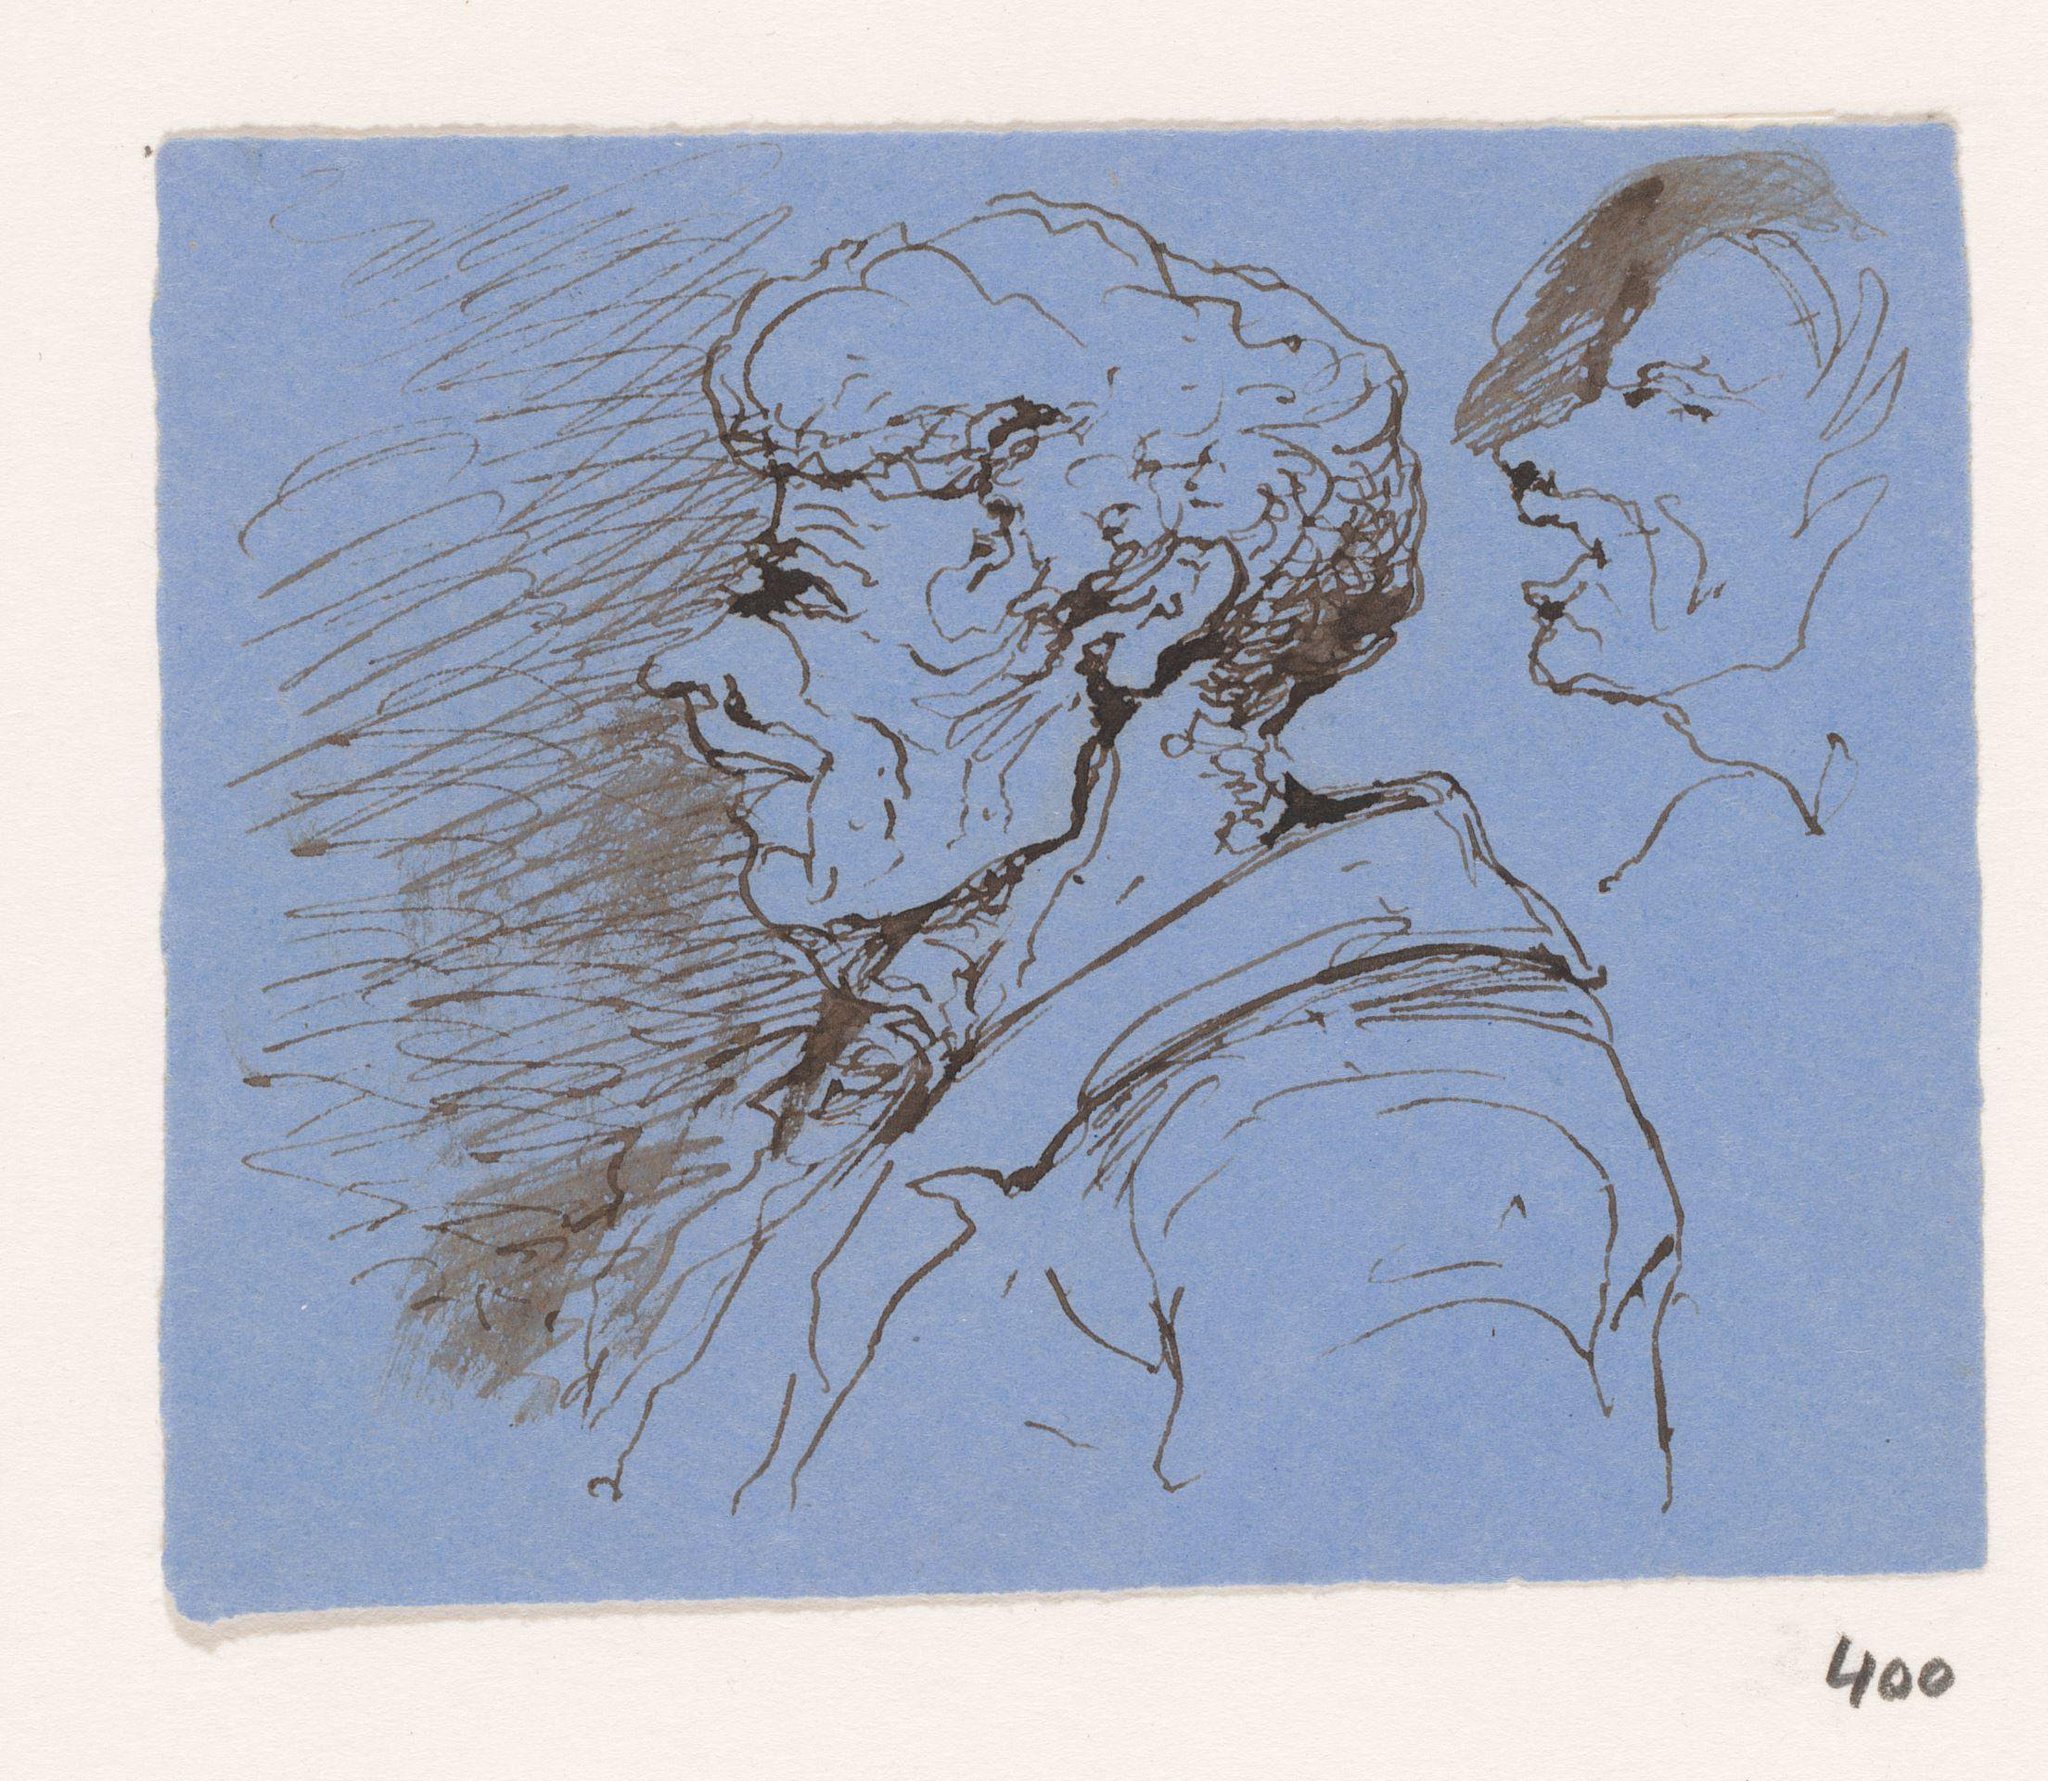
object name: drawing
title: Twee koppen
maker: johannes tavenraat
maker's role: draughtsman, painter, print maker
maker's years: 1809-1881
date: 1840-1880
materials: ink, paper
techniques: pen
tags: caricatures (human types)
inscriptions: collector's mark: Lugt 2228